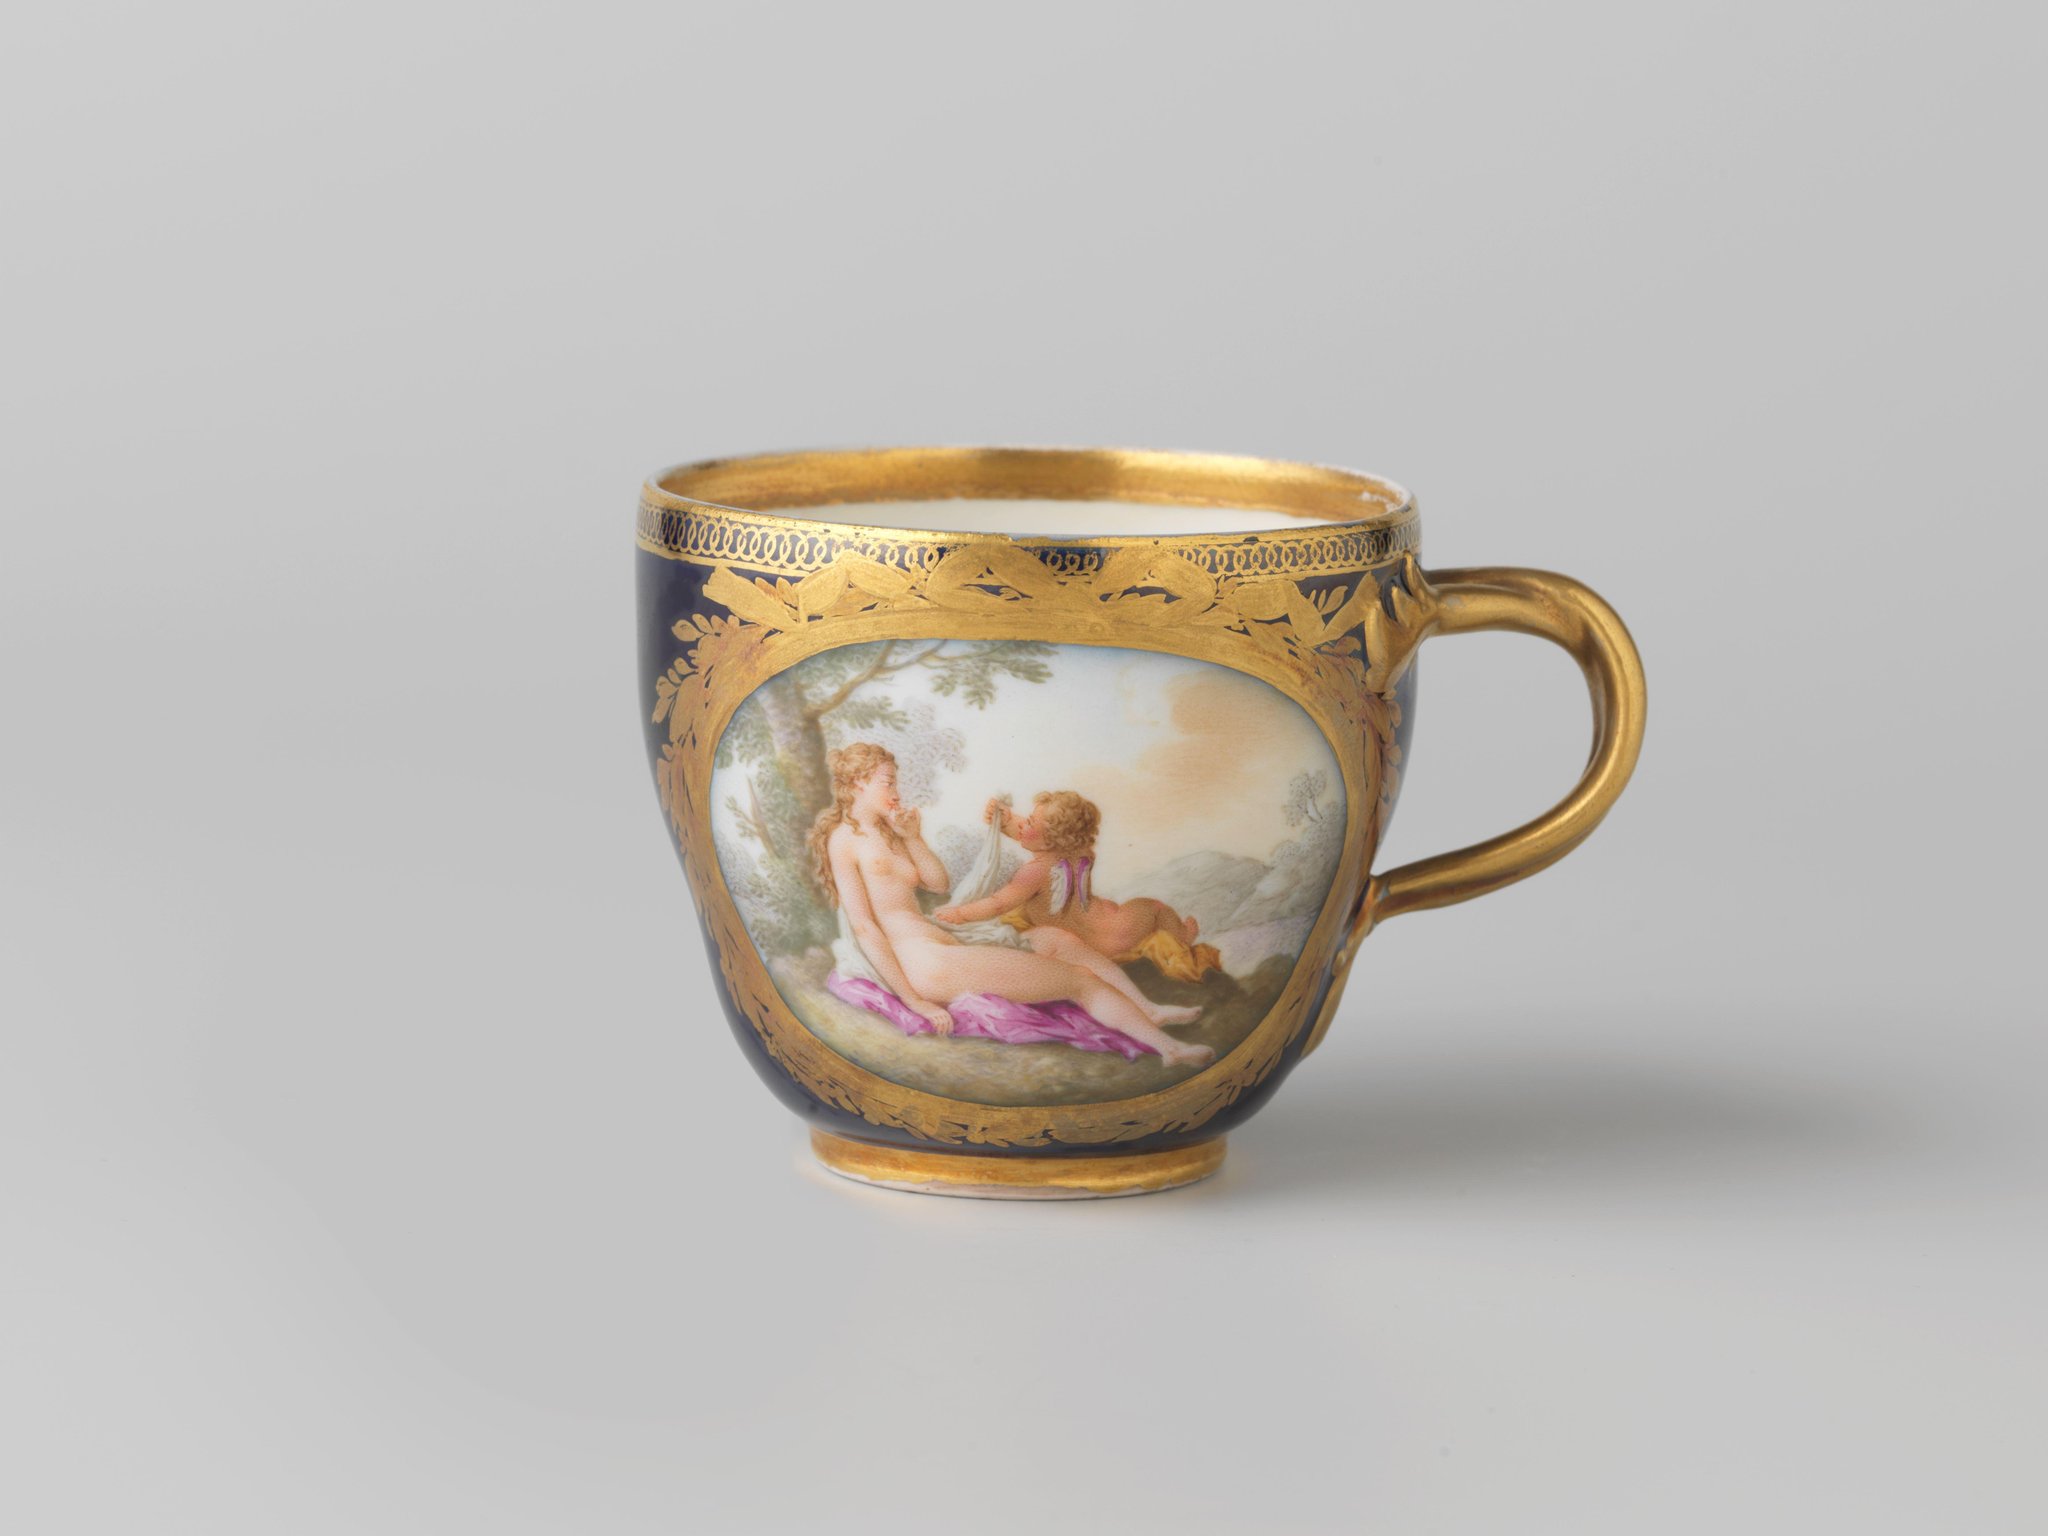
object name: cup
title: Kop, veelkleurig beschilderd met voorstellingen en het monogram AJK in medaillon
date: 1775-1780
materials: porcelain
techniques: painted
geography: meissen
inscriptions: factory mark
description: Cup and saucer with the arms of an unidentified family. Porcelain. Meissen, c. 1775 - 1780.